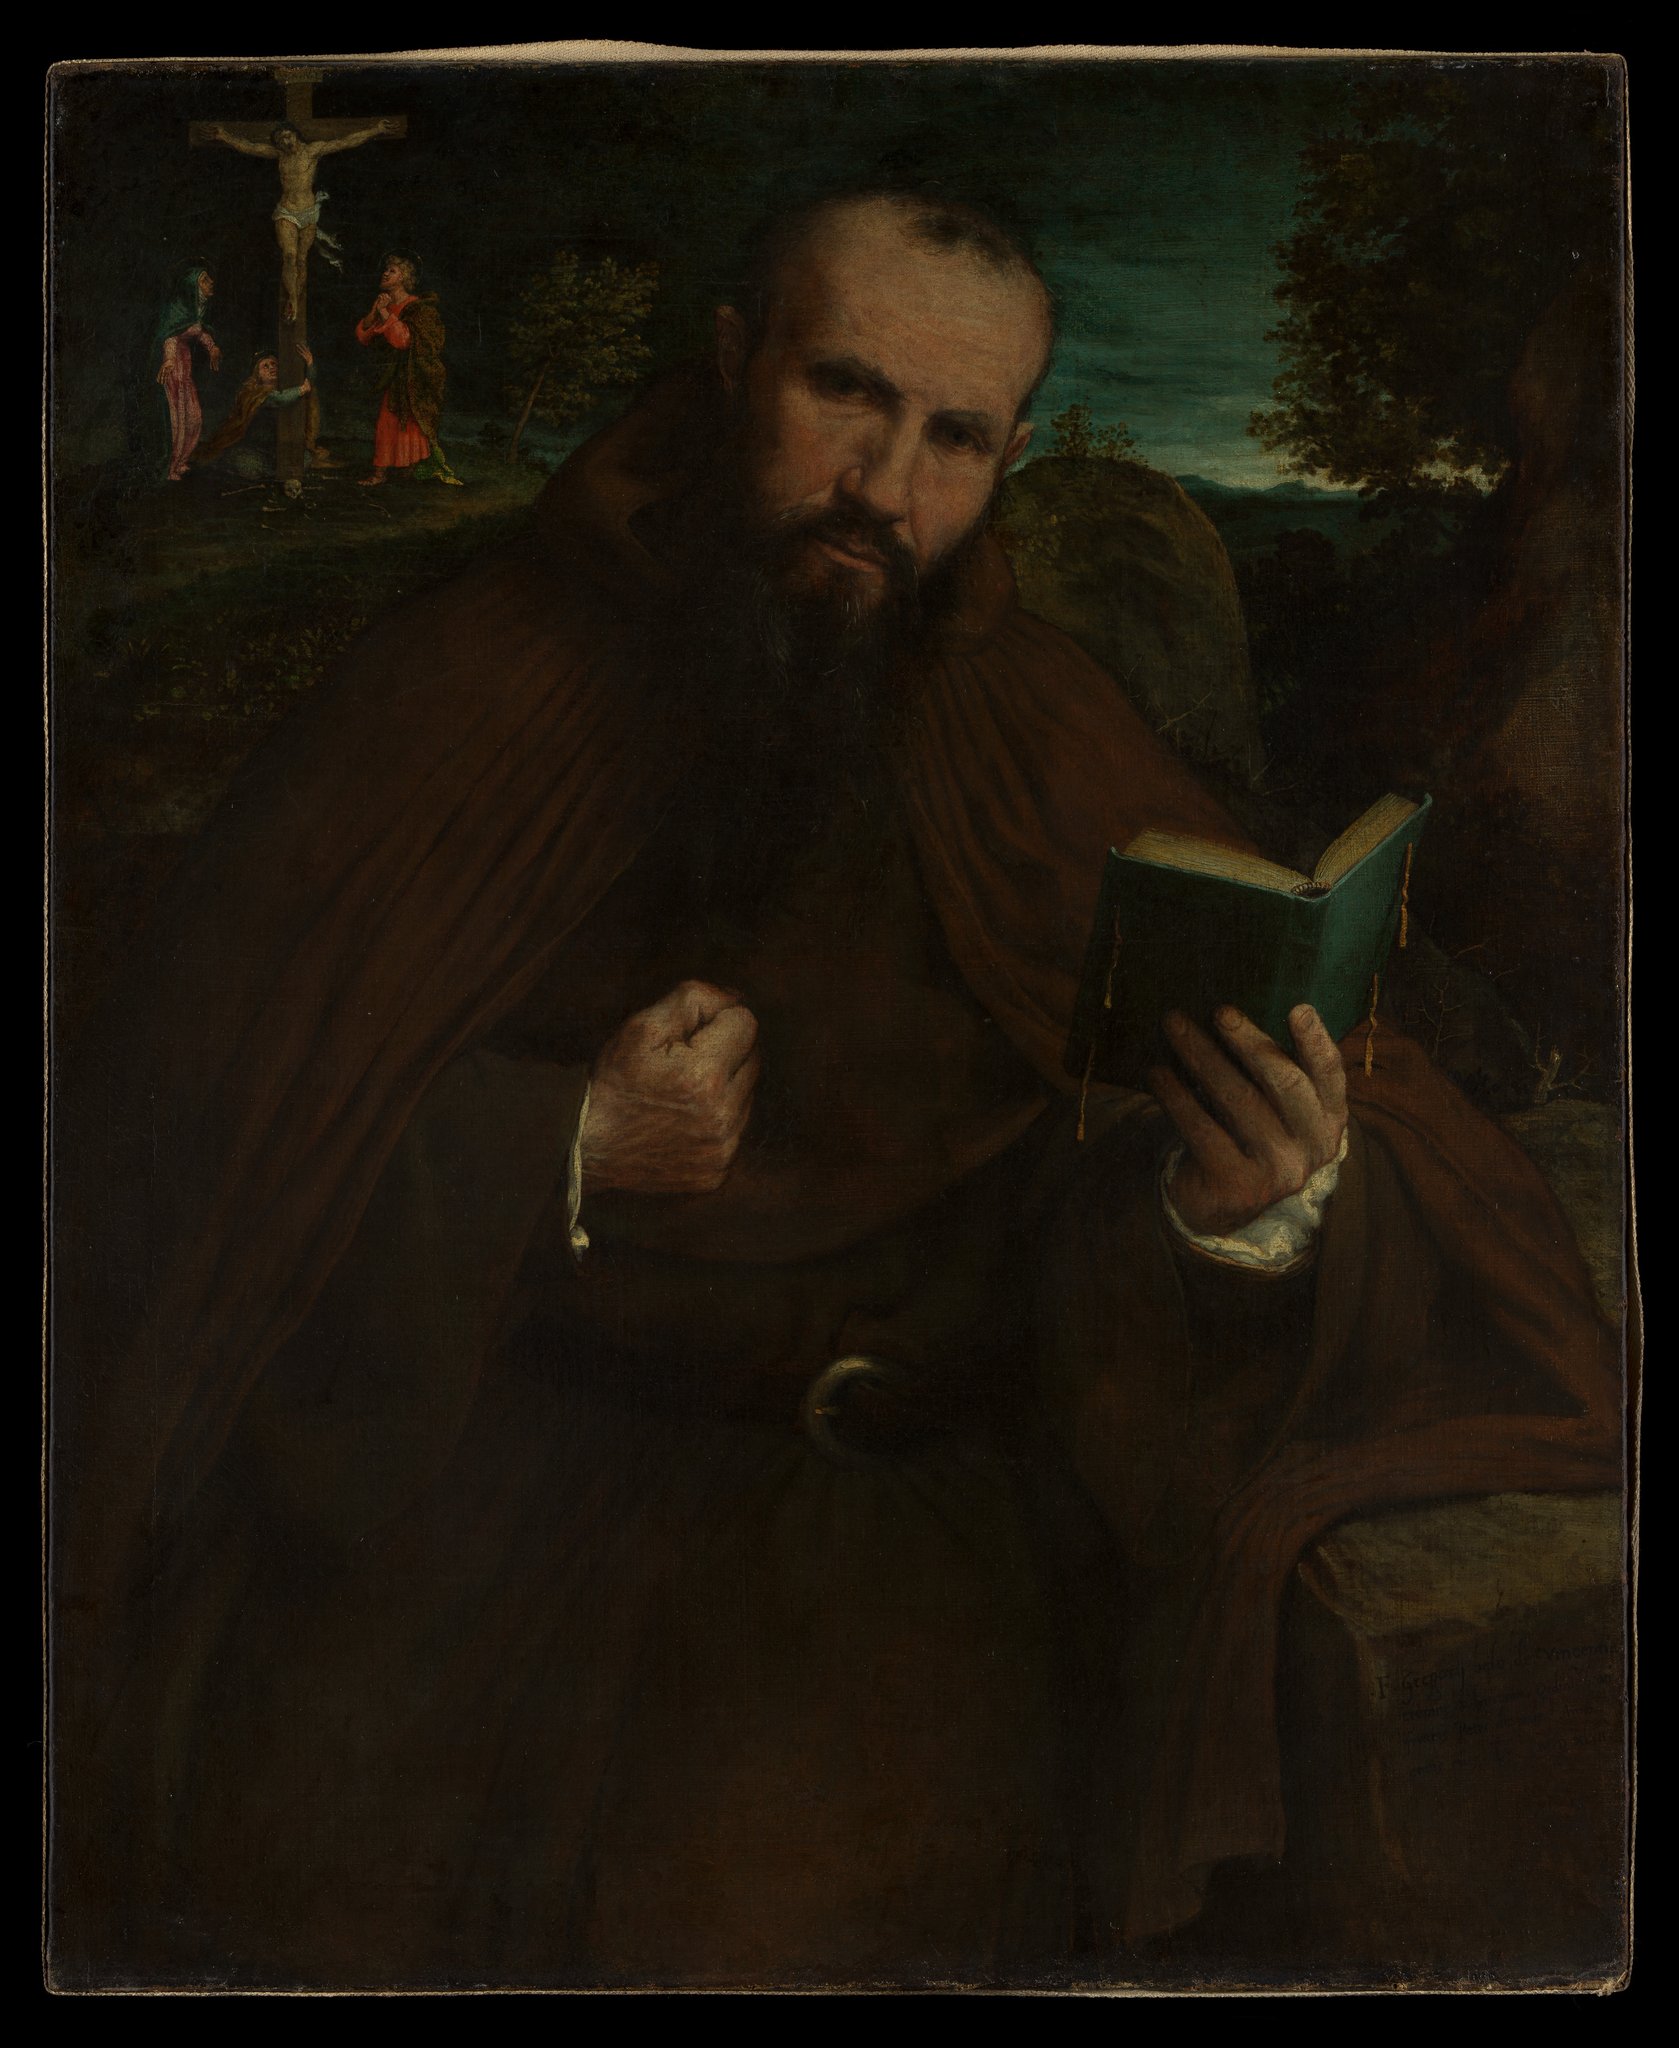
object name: painting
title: Brother Gregorio Belo of Vicenza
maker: lorenzo lotto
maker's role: artist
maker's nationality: italian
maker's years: 1475-1556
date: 1547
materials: canvas, oil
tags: books,men,portraits,christ,crucifixion